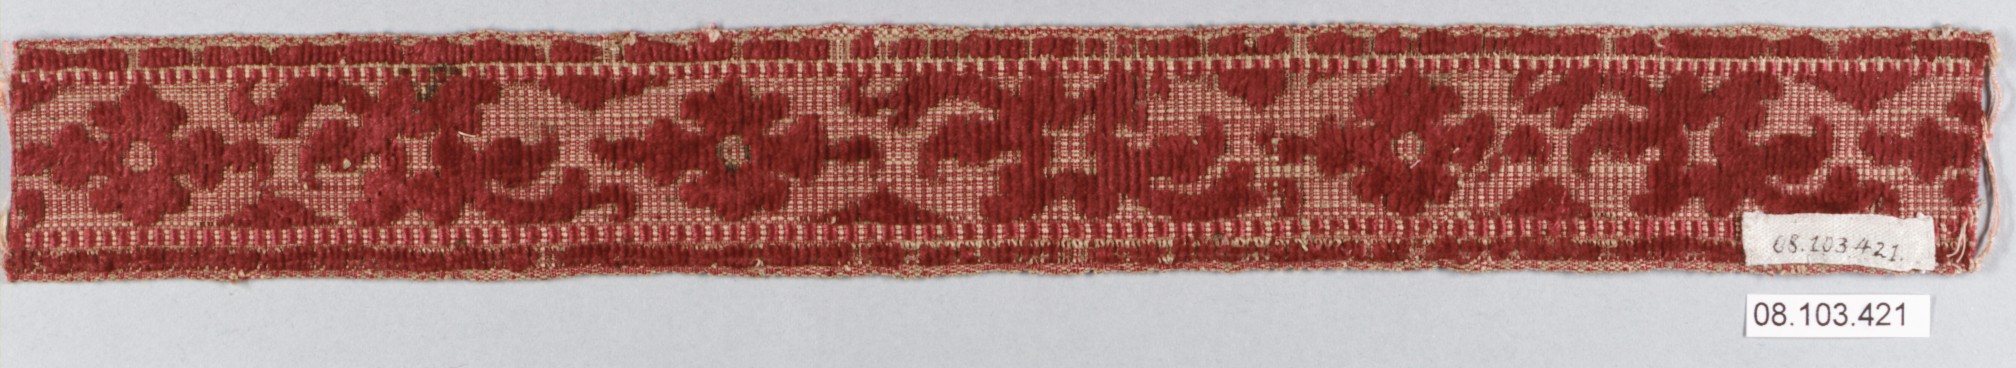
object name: galloon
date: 1601-1700